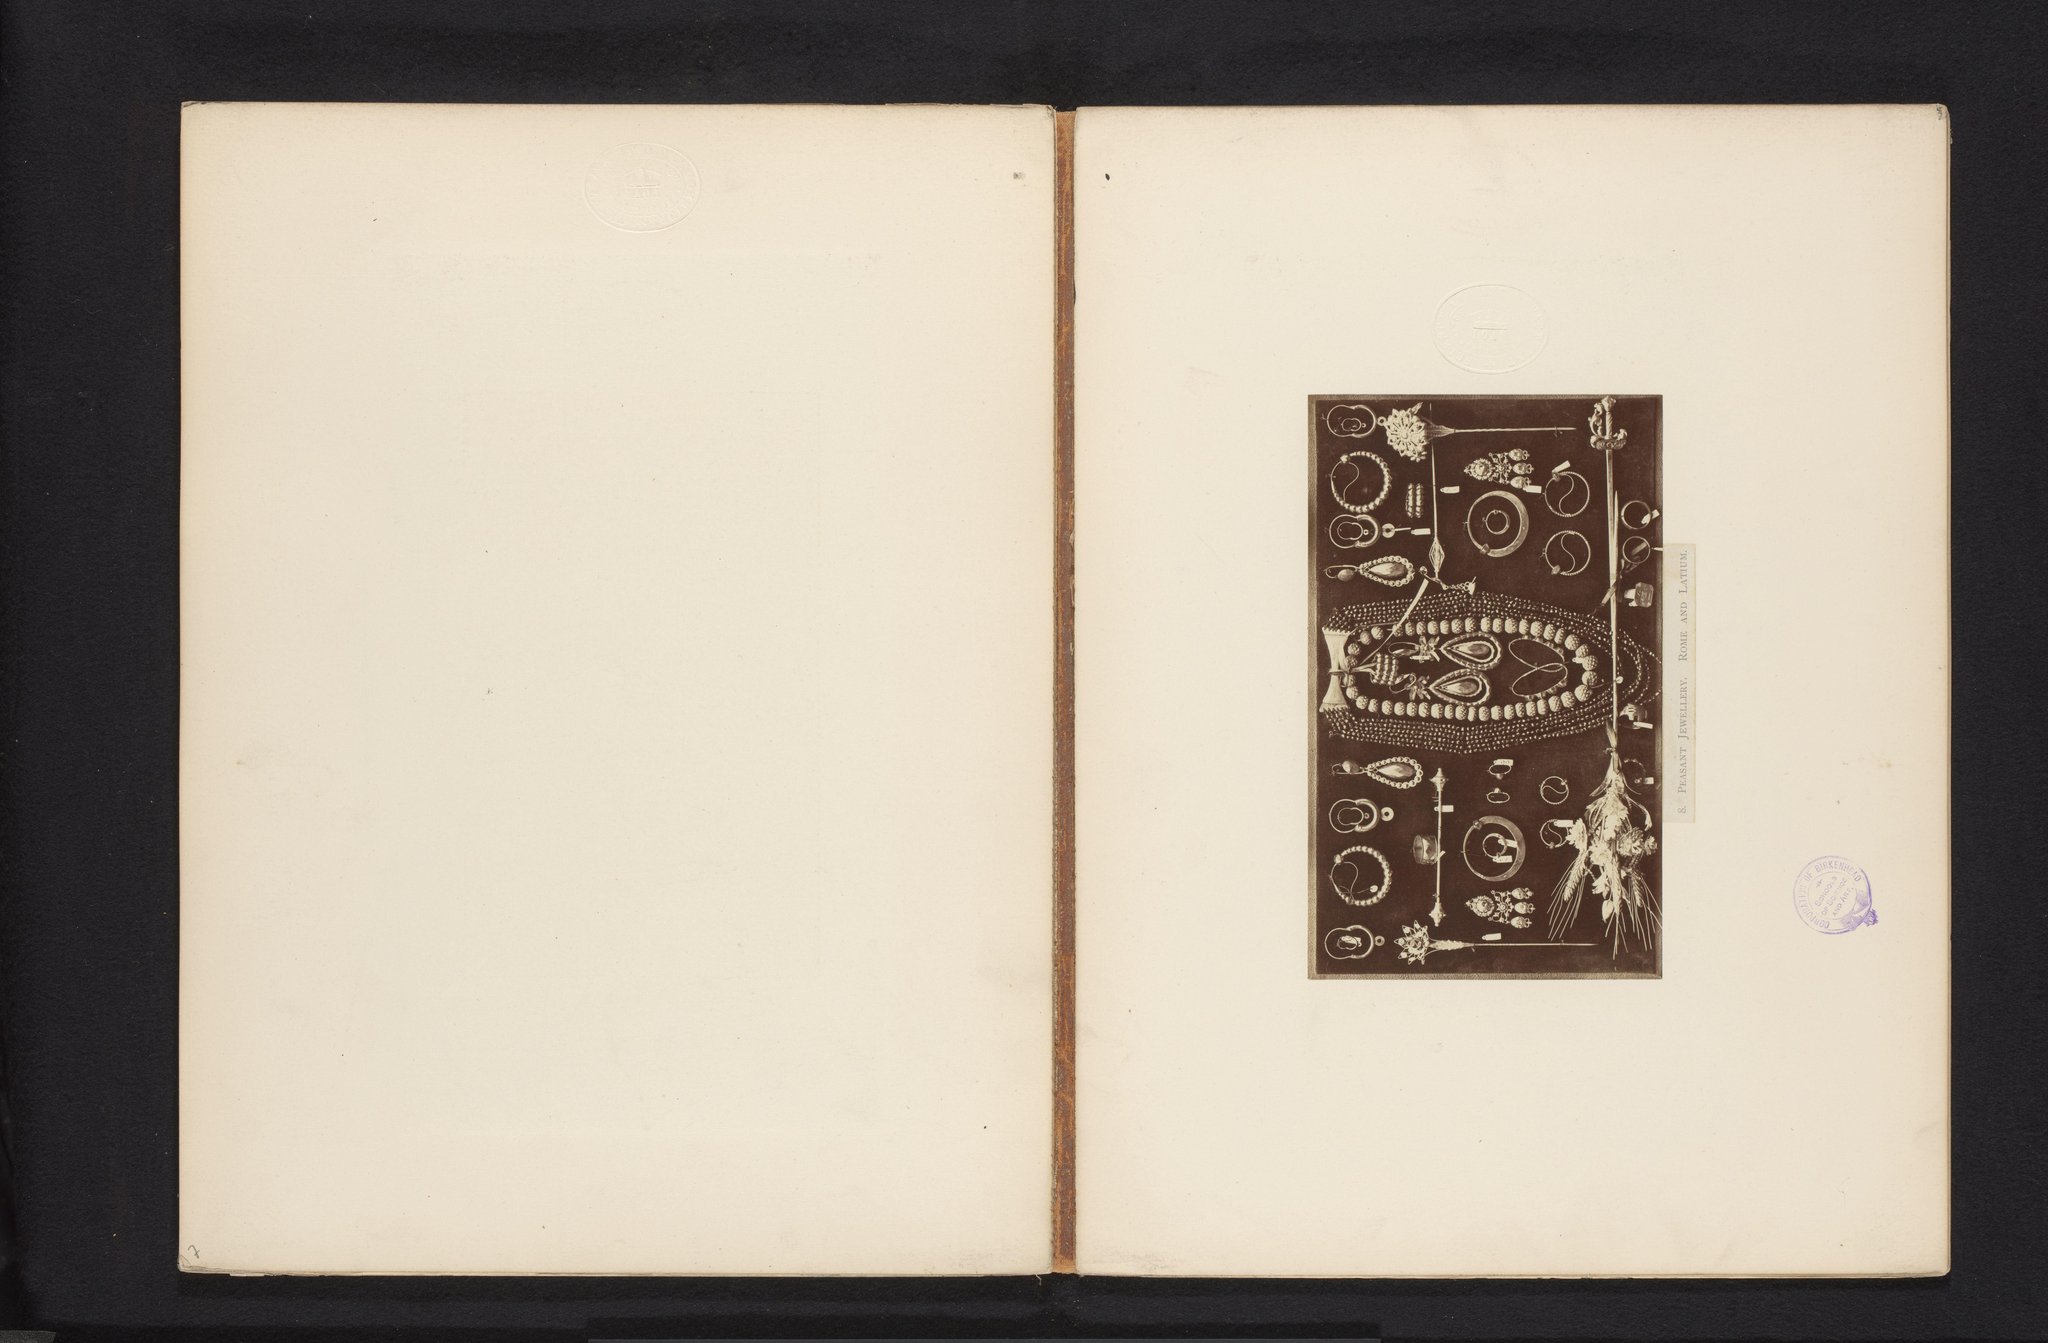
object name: photograph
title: Peasant Jewellery. Rome and Latium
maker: Anonymous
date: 1863-1868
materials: photographic support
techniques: albumen print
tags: ornaments, jewels, necklace, ear-rings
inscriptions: collector's mark: ‘South Kensington/ Science and art department’, collector's mark: ‘Corporation of Birkenhead/ schools of science and art’